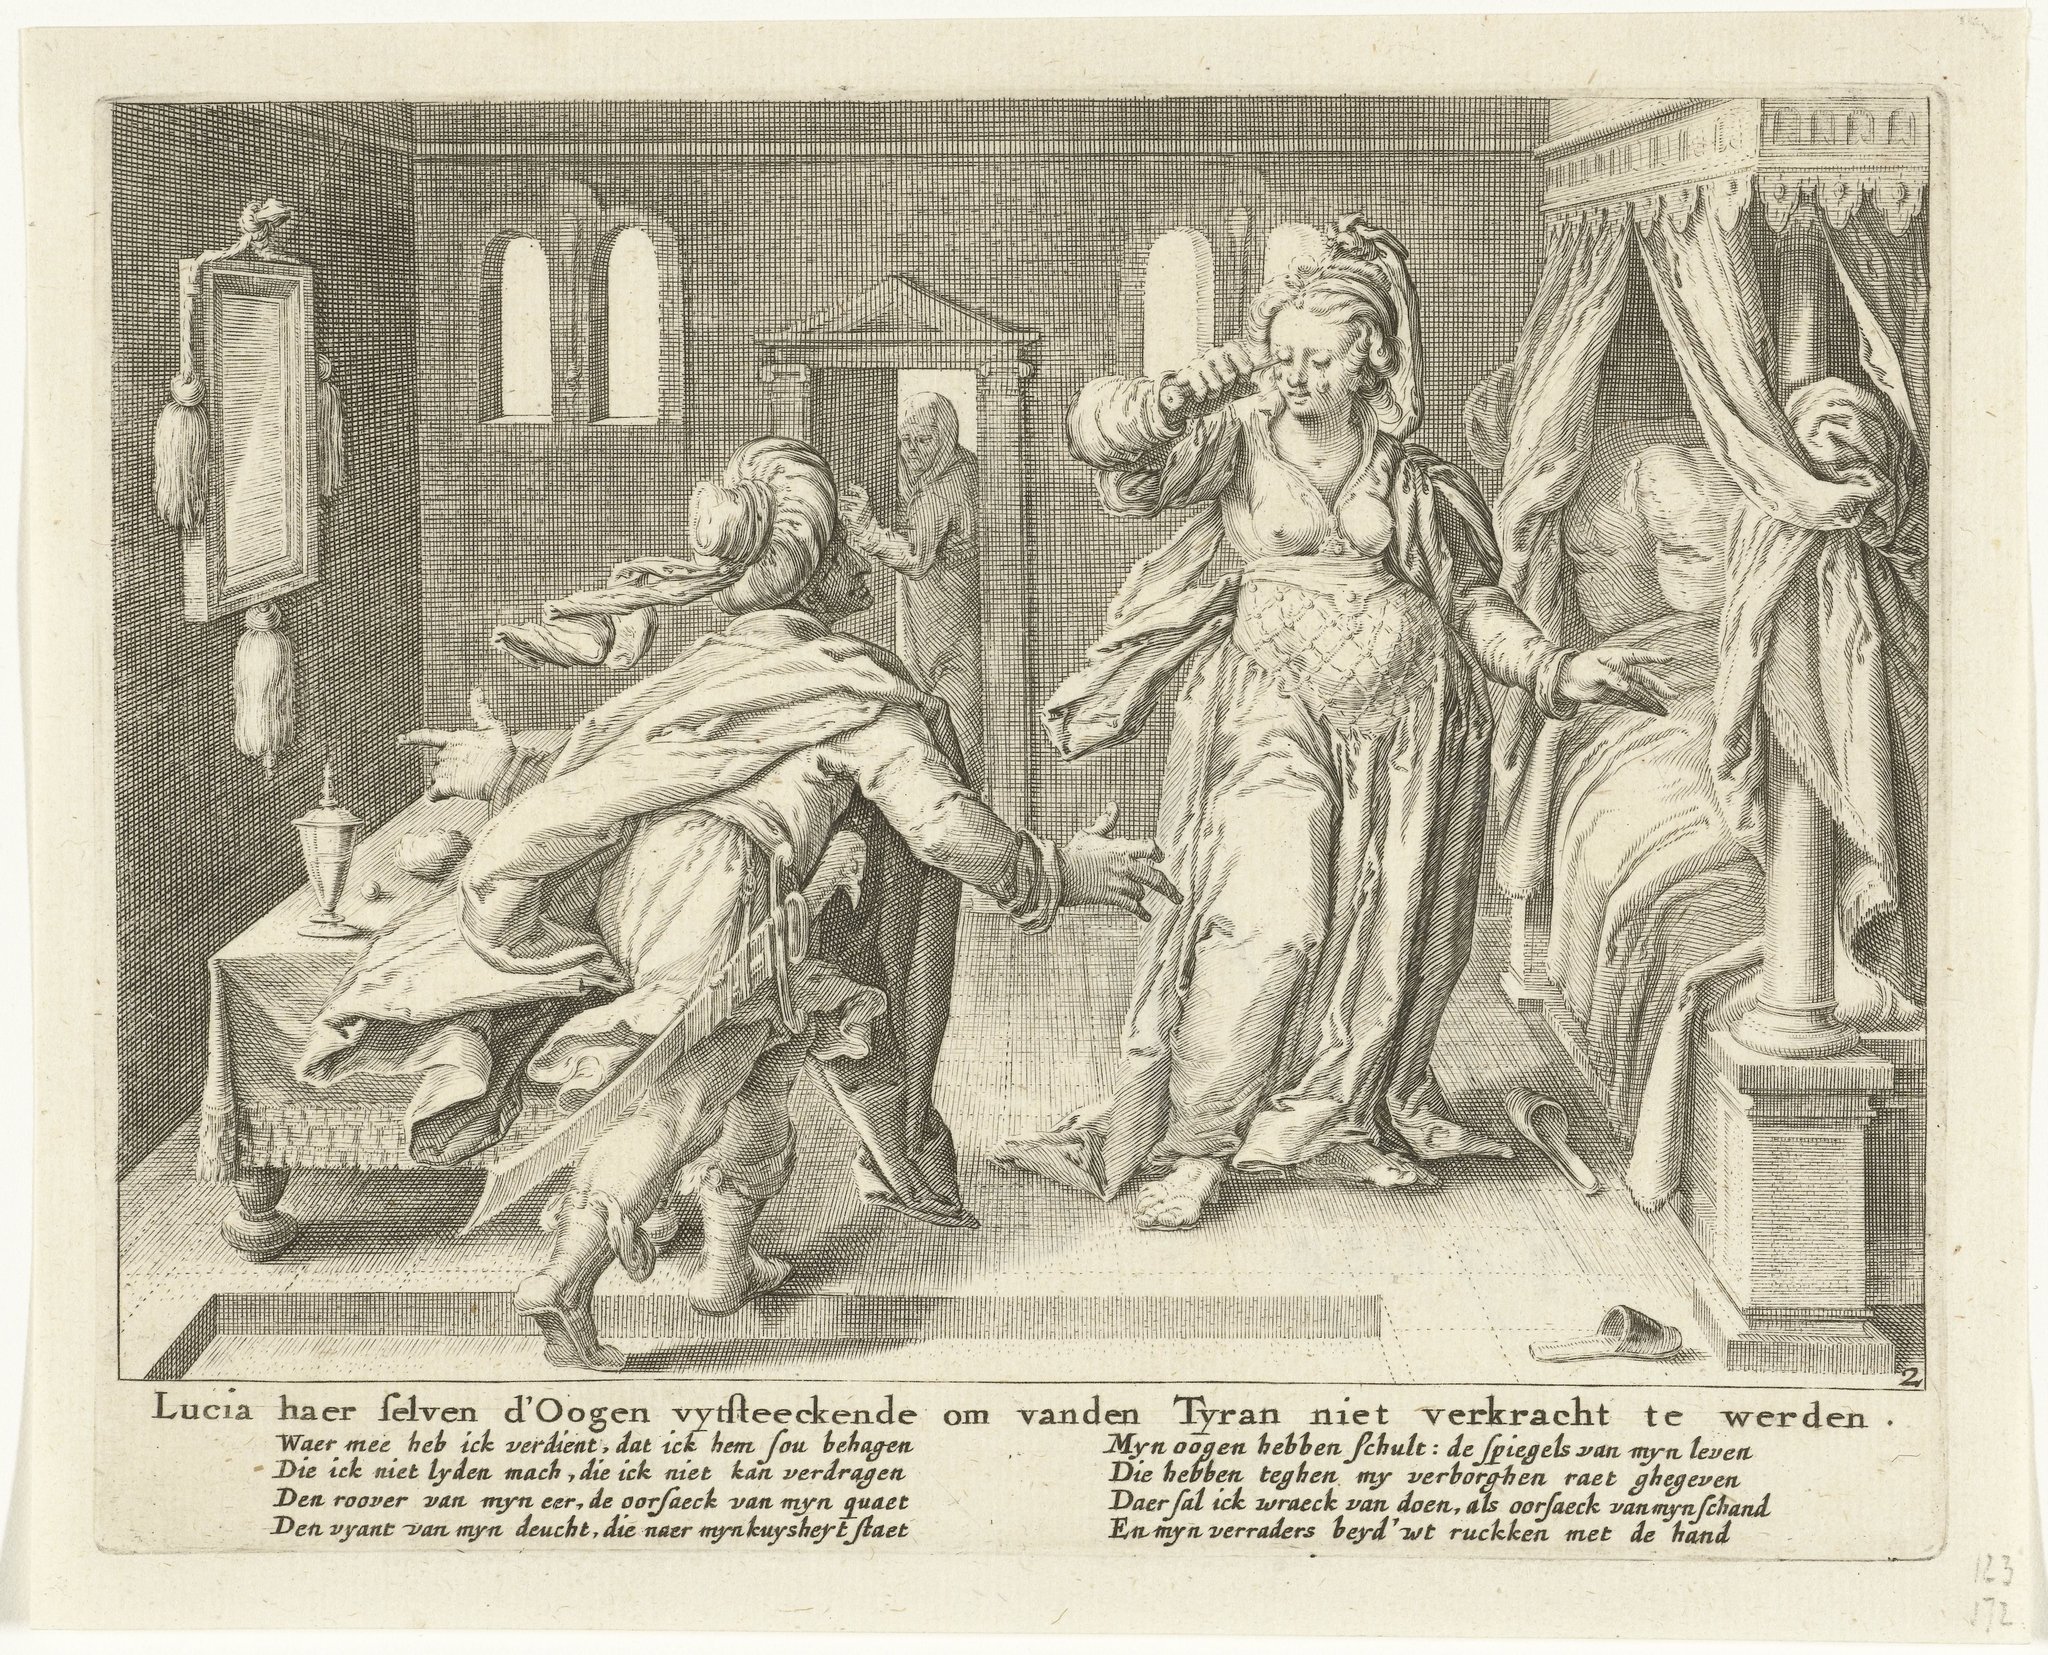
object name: print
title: Spiegel vande Doorluchtige, eerlicke, Cloucke, Deuchtsame ende verstandege vrouwen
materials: paper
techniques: engraving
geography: leiden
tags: suffering, misfortune of lucretia - apotheosis, deification of person from classical history, death of lucretia: she commits suicide by stabbing herself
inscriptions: collector's mark: Lugt 2228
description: Lucretia staat in haar slaapkamer naast het bed. Ze is verkracht door Sixtus de zoon van de tiran Tarquinius. Uit schaamte steekt ze zelf haar ogen uit. Een bediende snelt naar haar toe om haar tegen te houden. Bladzijde uit een boek met tekst op het verso.